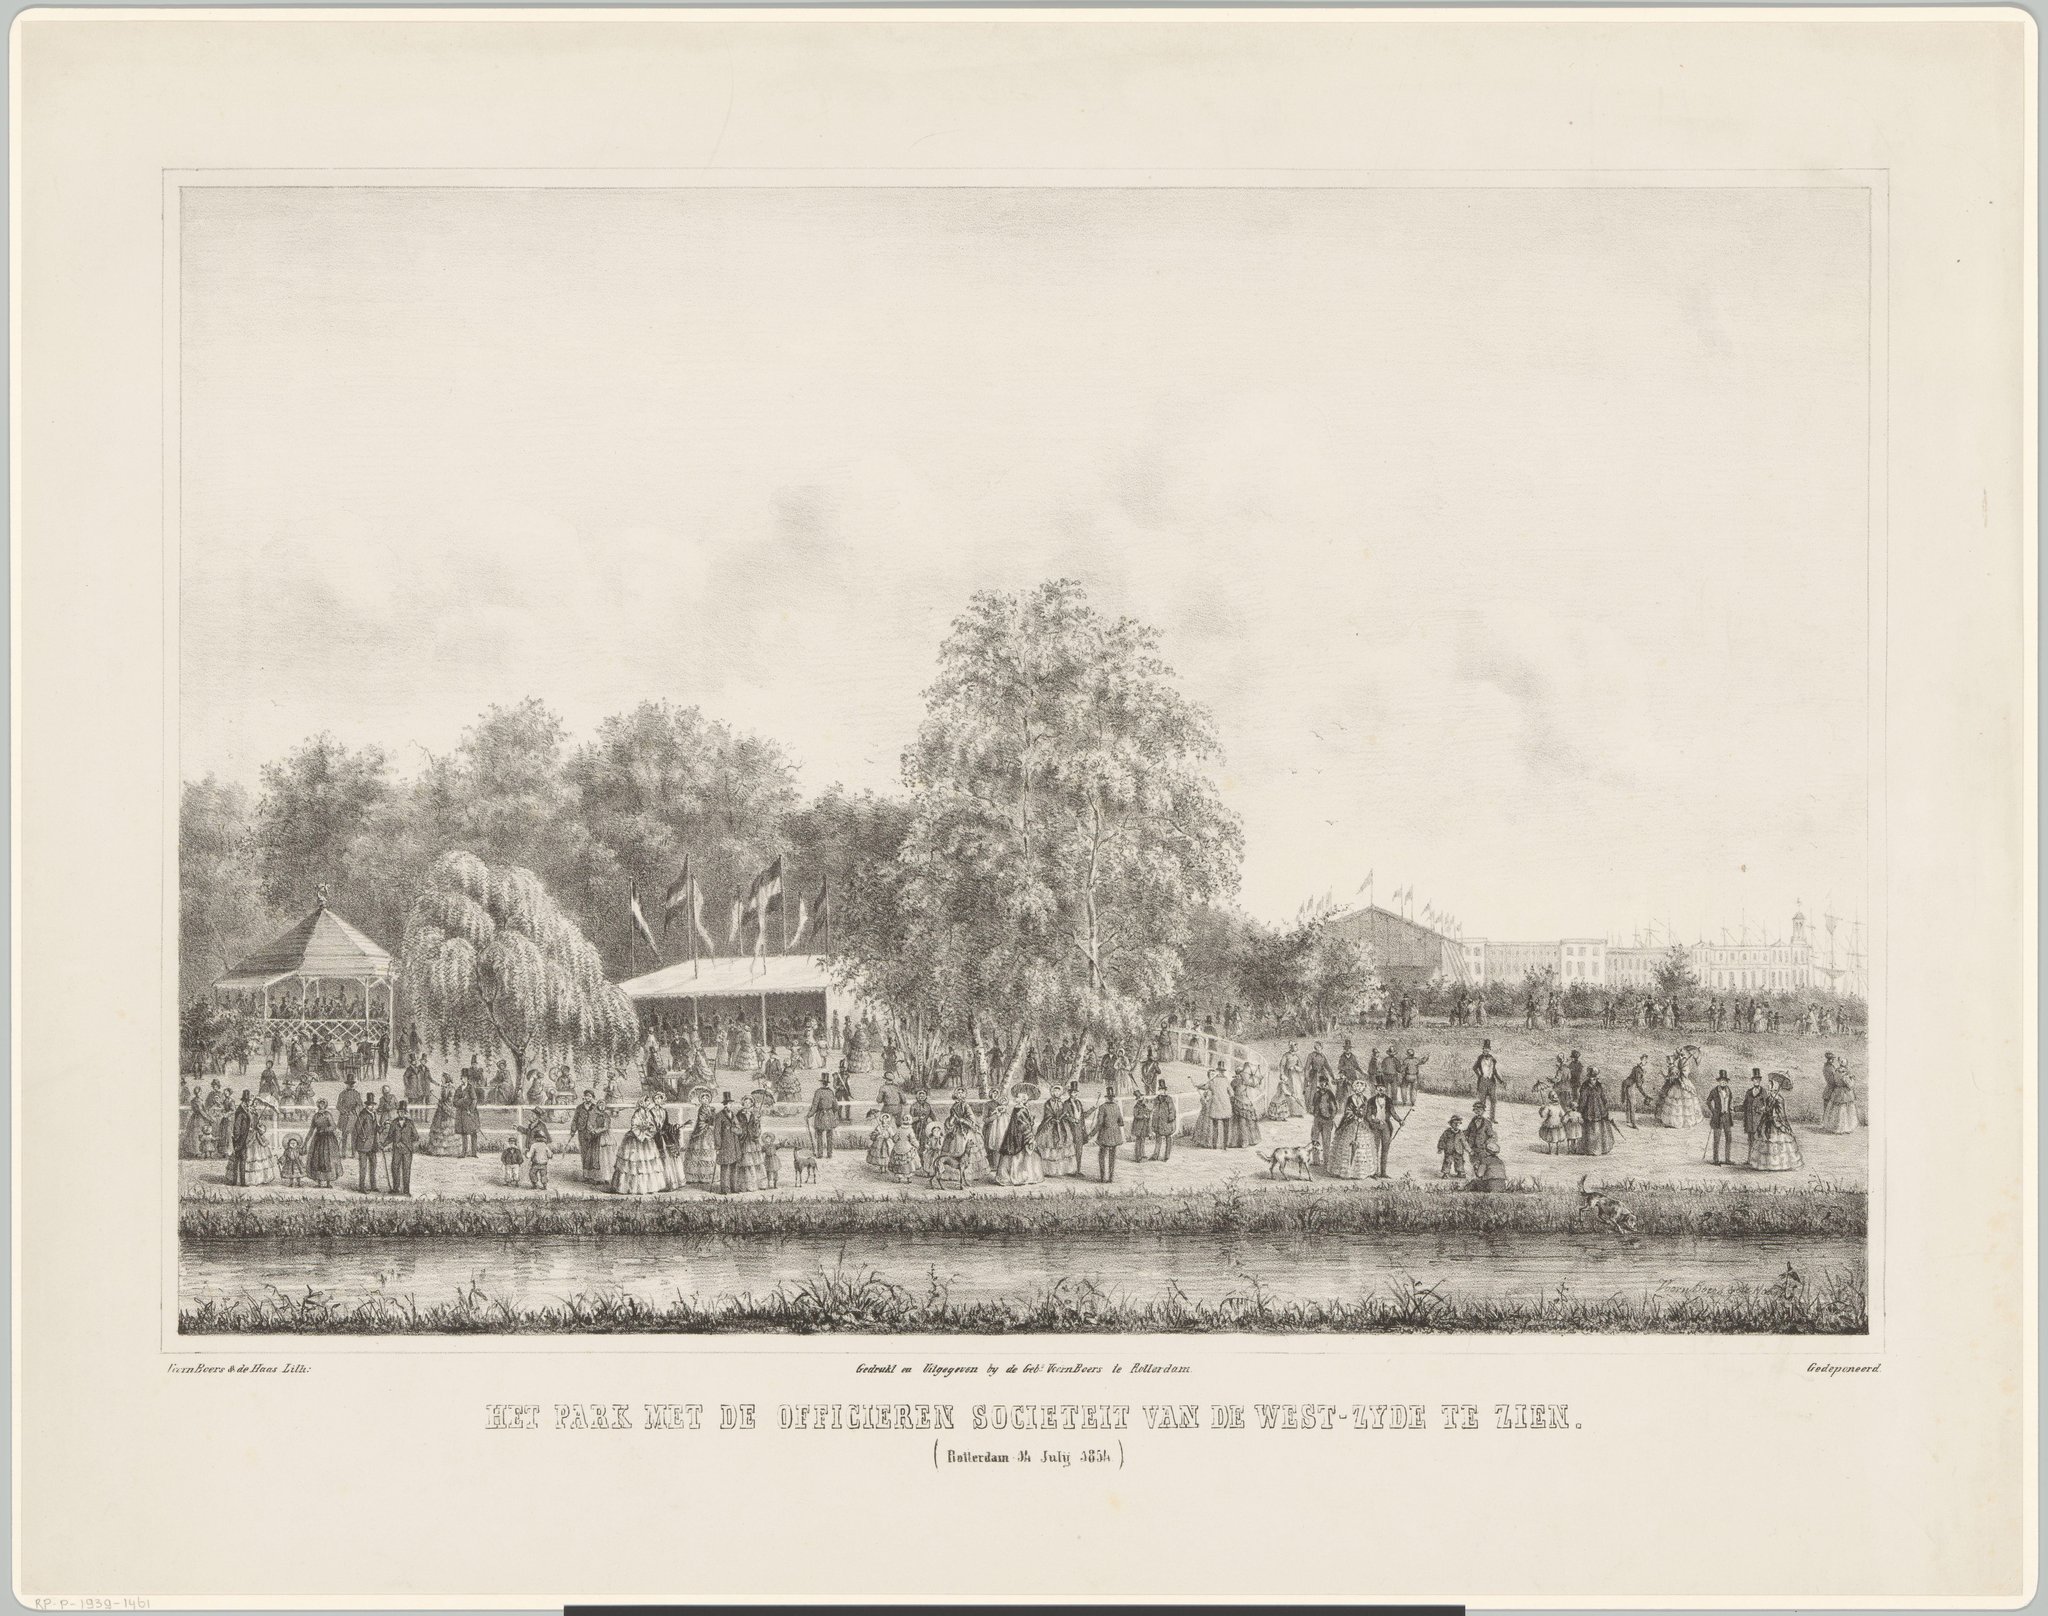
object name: print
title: Het park met de officieren Societeit van de West-zyde te zien (Rottterdam 14 Julij 1854)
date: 1854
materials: paper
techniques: lithograph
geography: rotterdam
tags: park, rotterdam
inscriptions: collector's mark: Lugt 2760, collector's mark: Lugt 2228, : ‘Gedeponeerd.’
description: Mensen in het park bij de officierssociëteit en muziektent te Rotterdam.